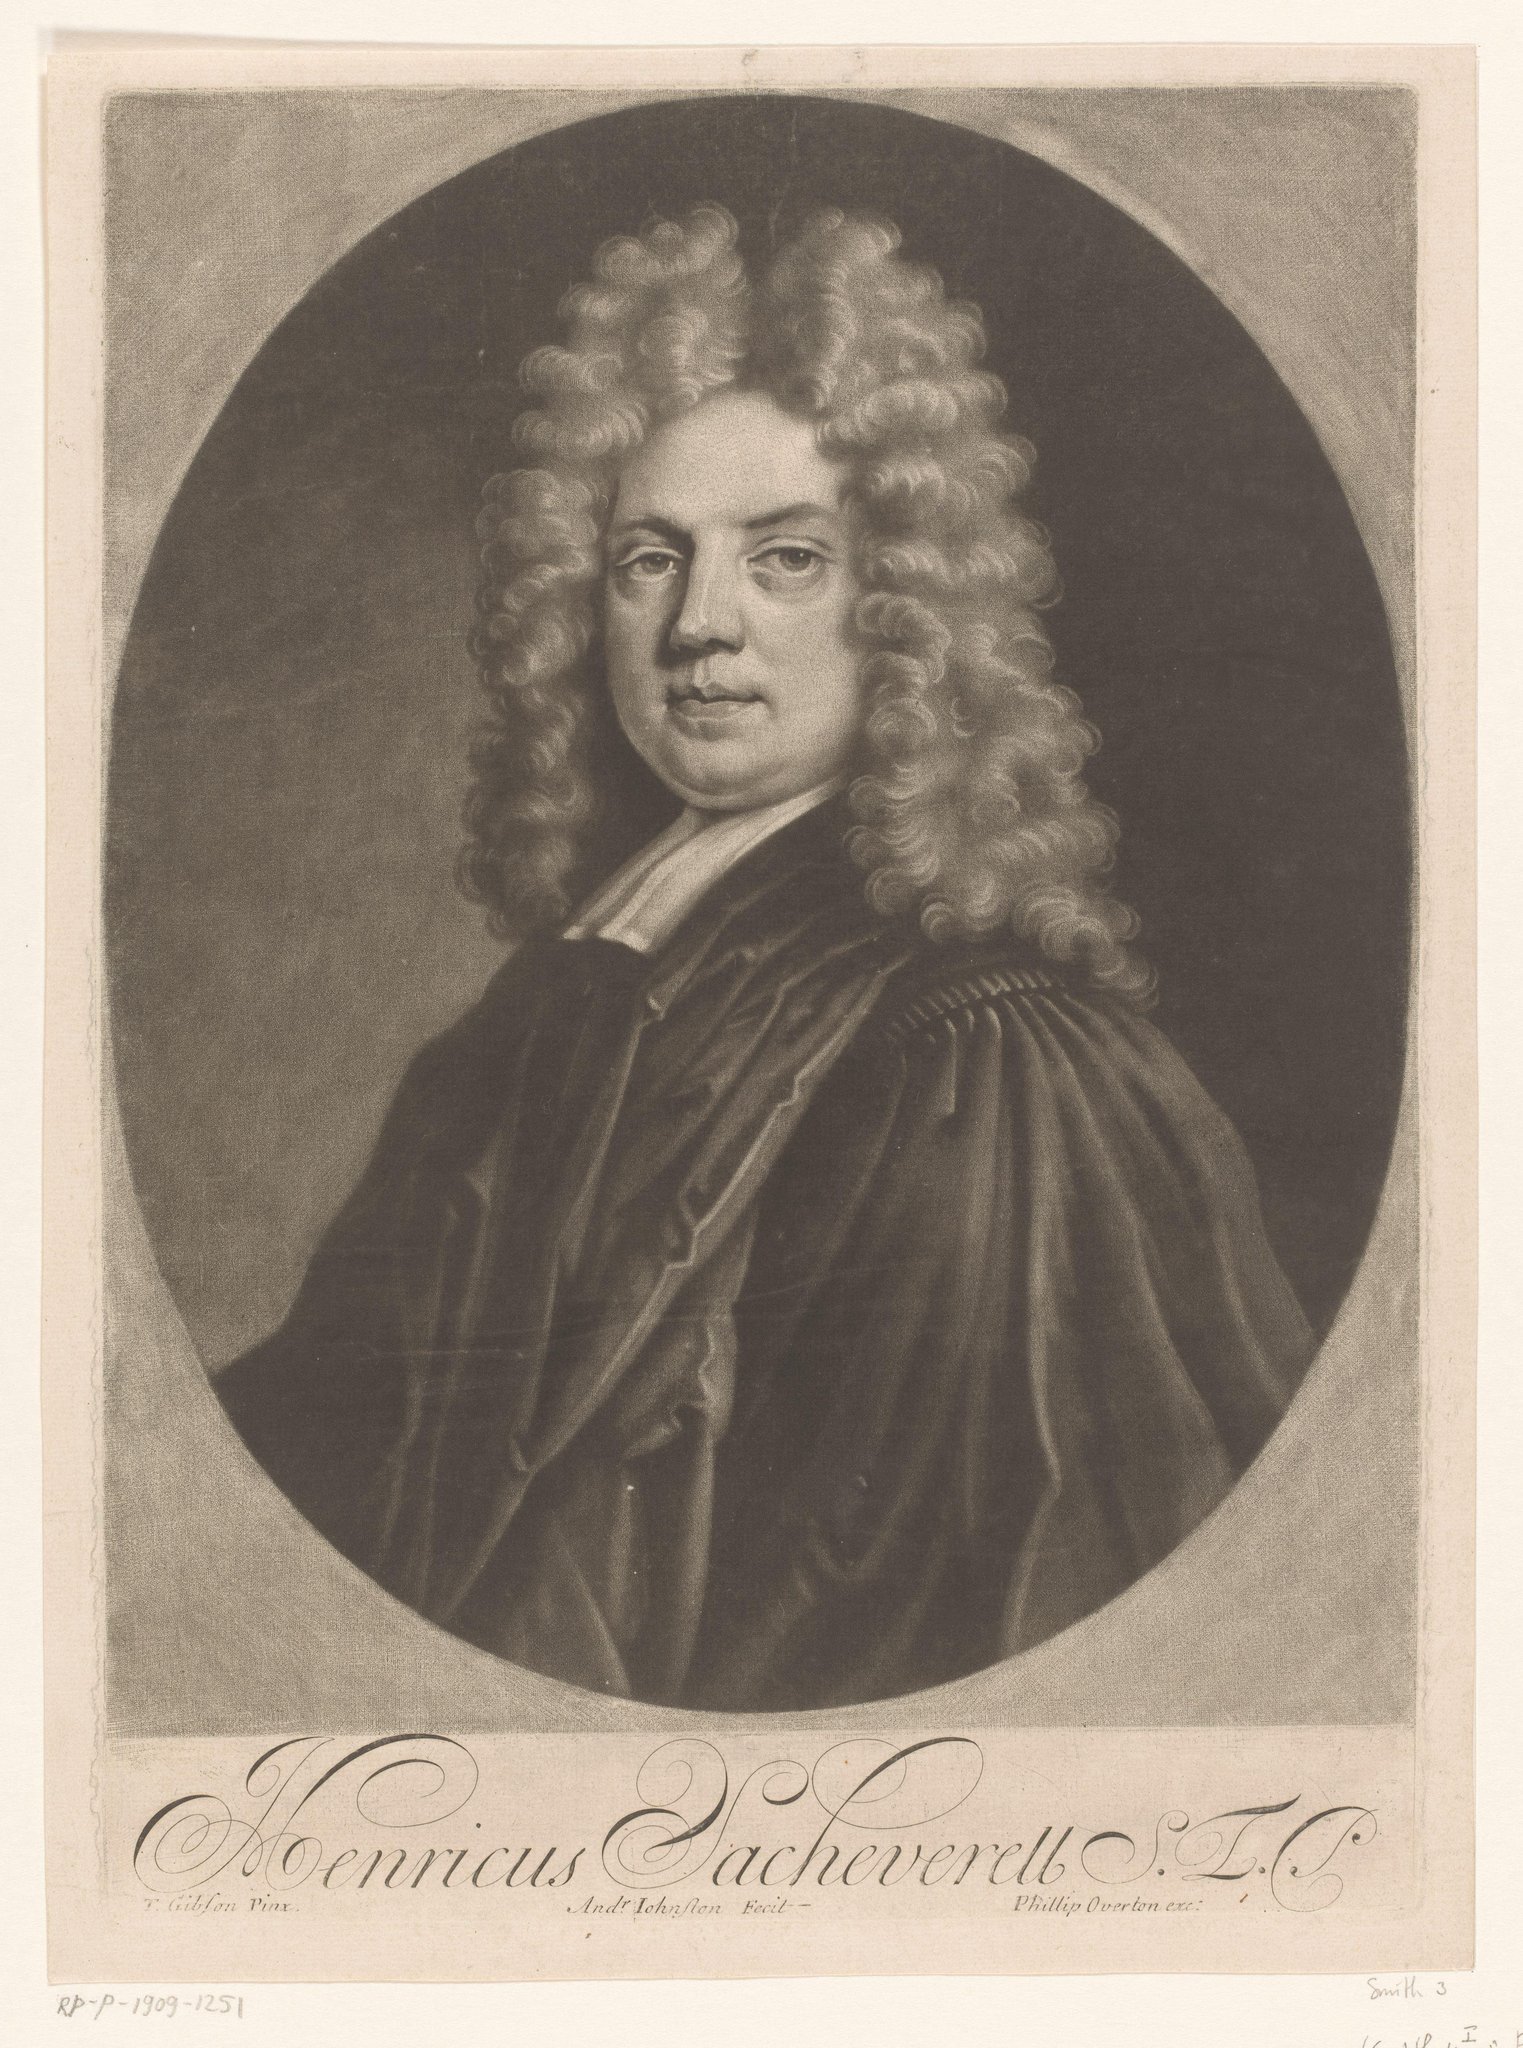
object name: print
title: Portret van Henry Sacheverell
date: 1700-1718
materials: paper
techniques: mezzotint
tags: theologian, historical persons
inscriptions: collector's mark: Lugt 2228